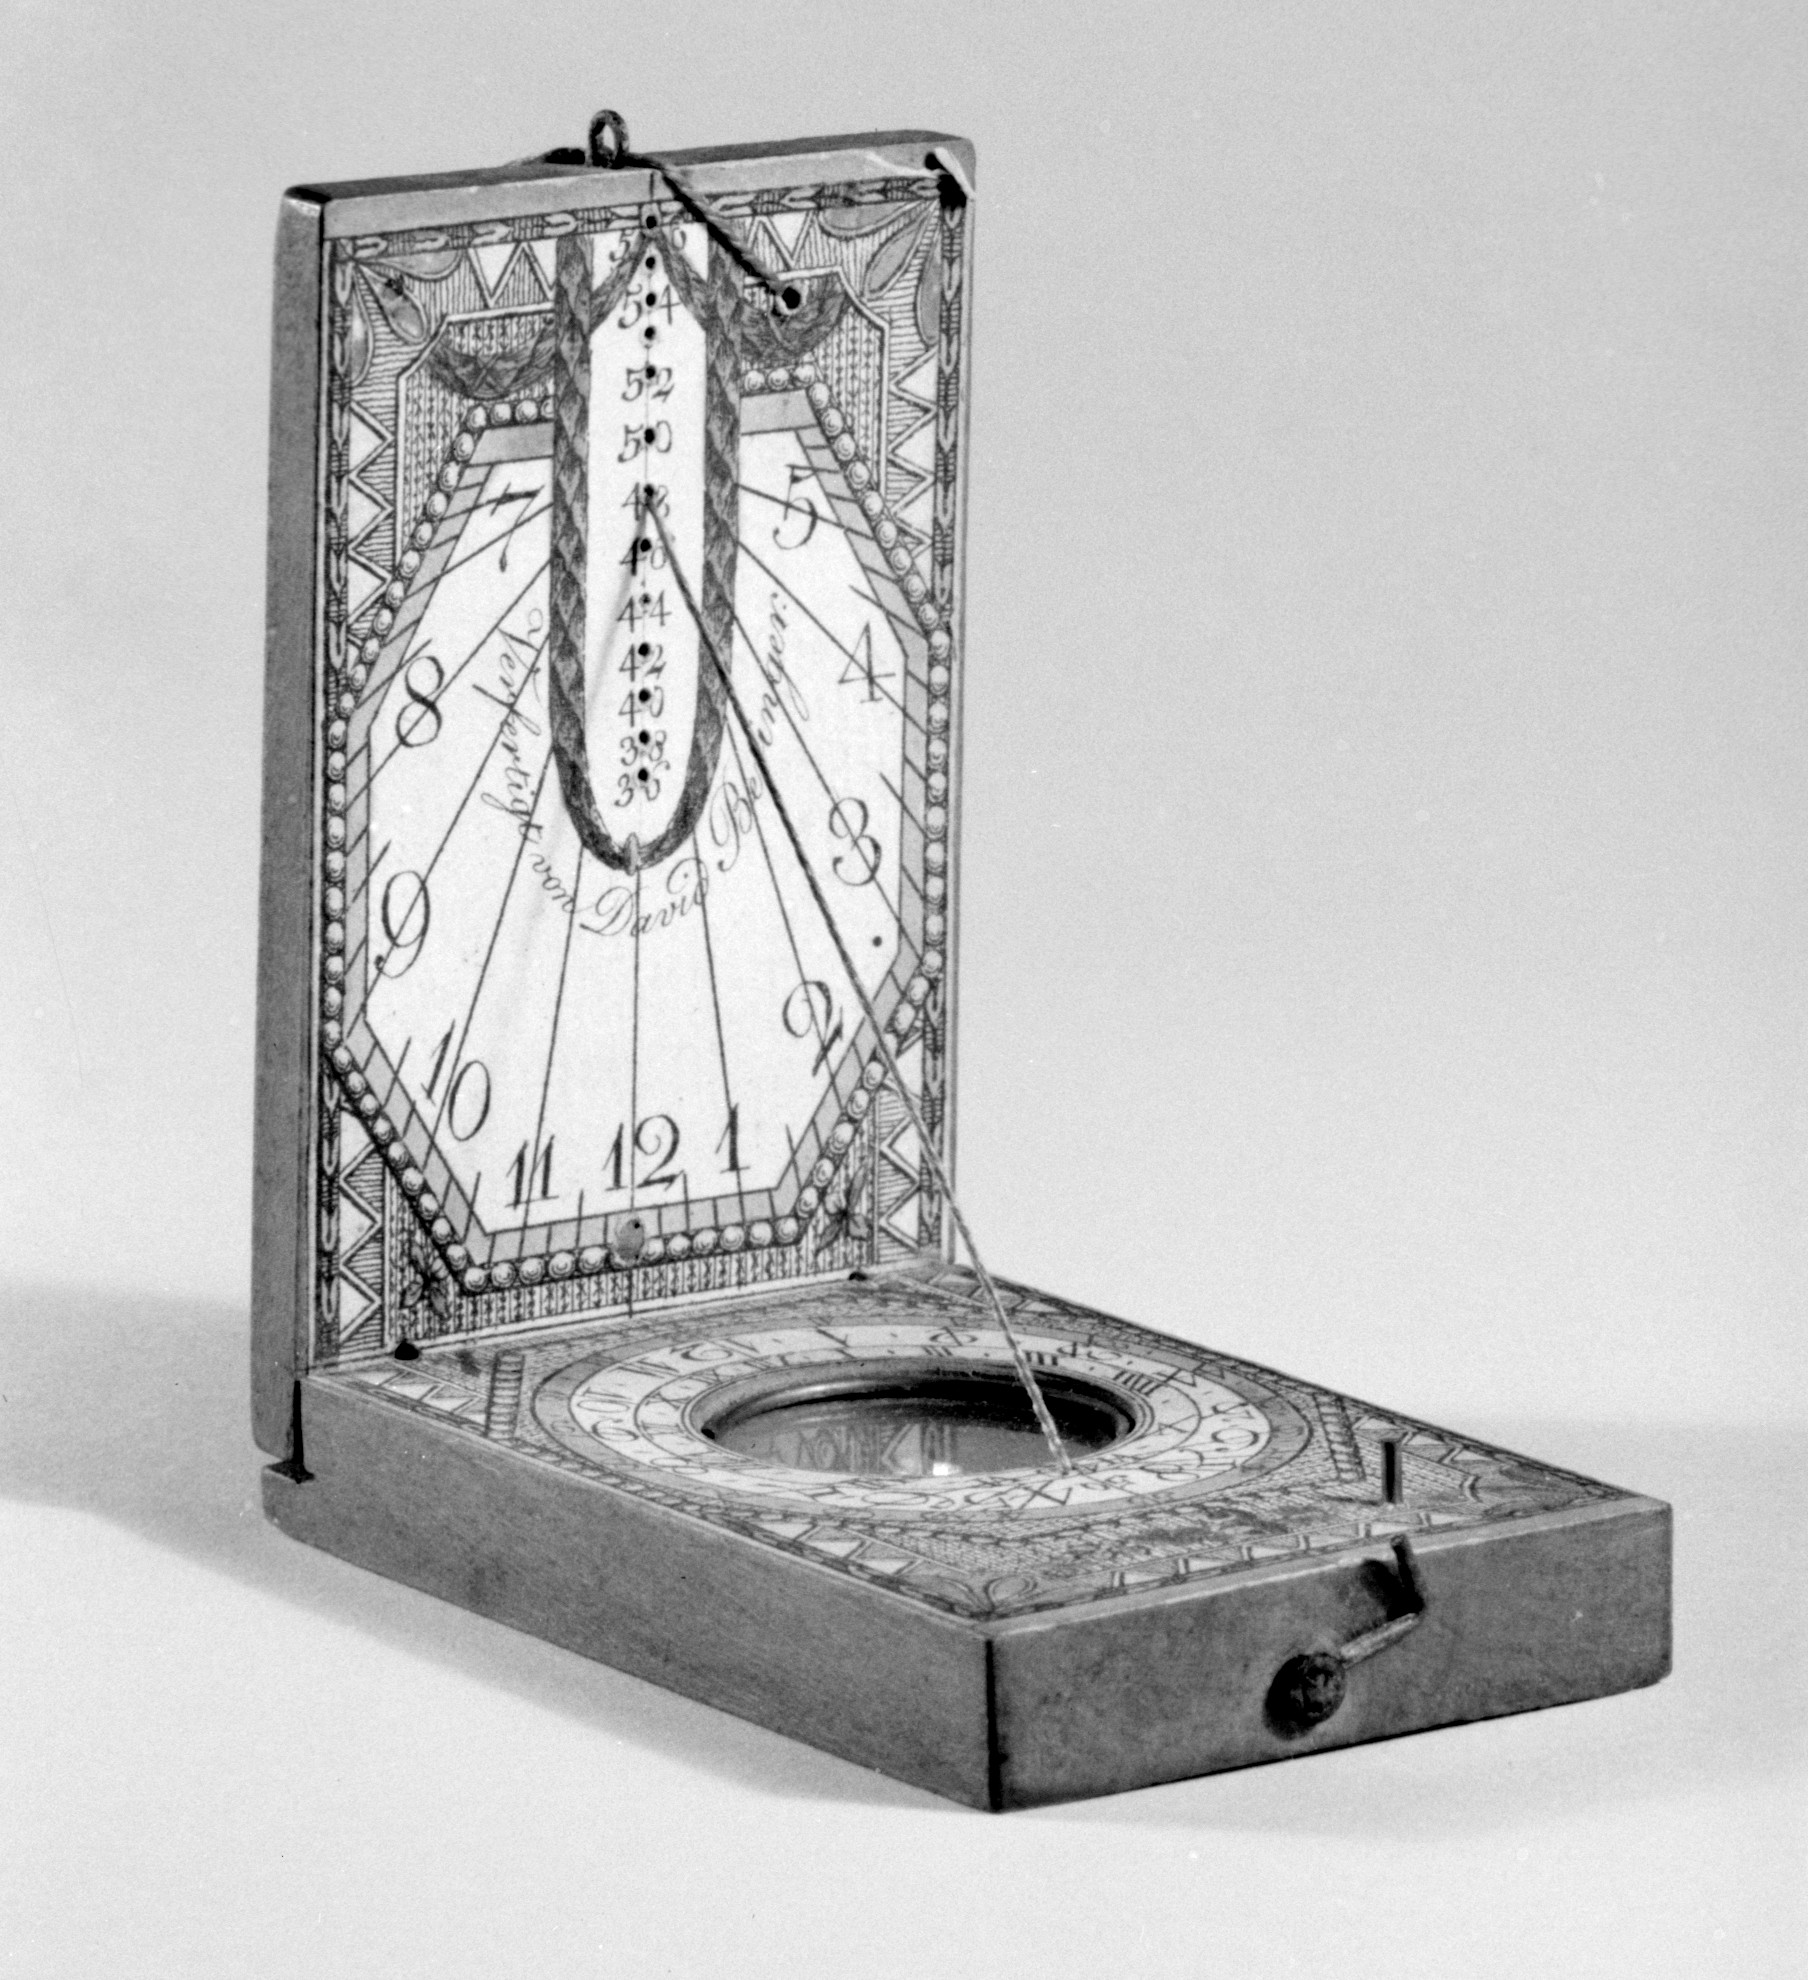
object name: portable diptych sundial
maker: david beringer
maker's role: maker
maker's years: 1756-1821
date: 1780-1821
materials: wood, paper